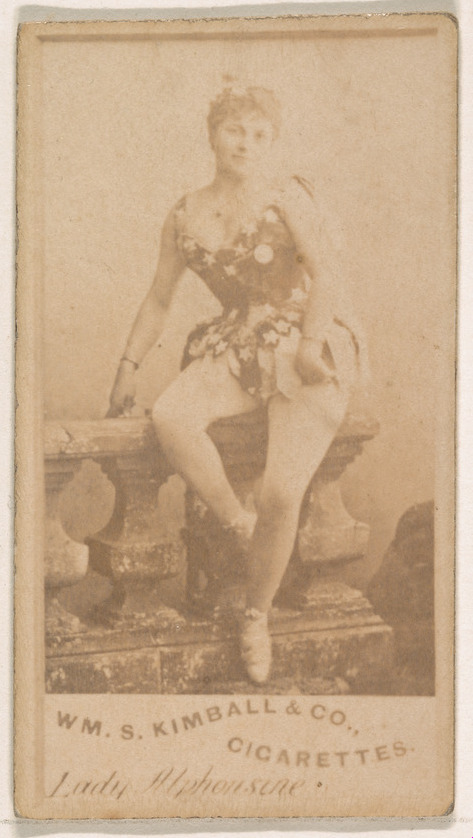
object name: photograph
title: Lady Alphonsene, from the Actresses series (N203) issued by Wm. S. Kimball & Co.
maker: william s. kimball & company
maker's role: publisher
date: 1889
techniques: color lithograph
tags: portraits,women,actresses